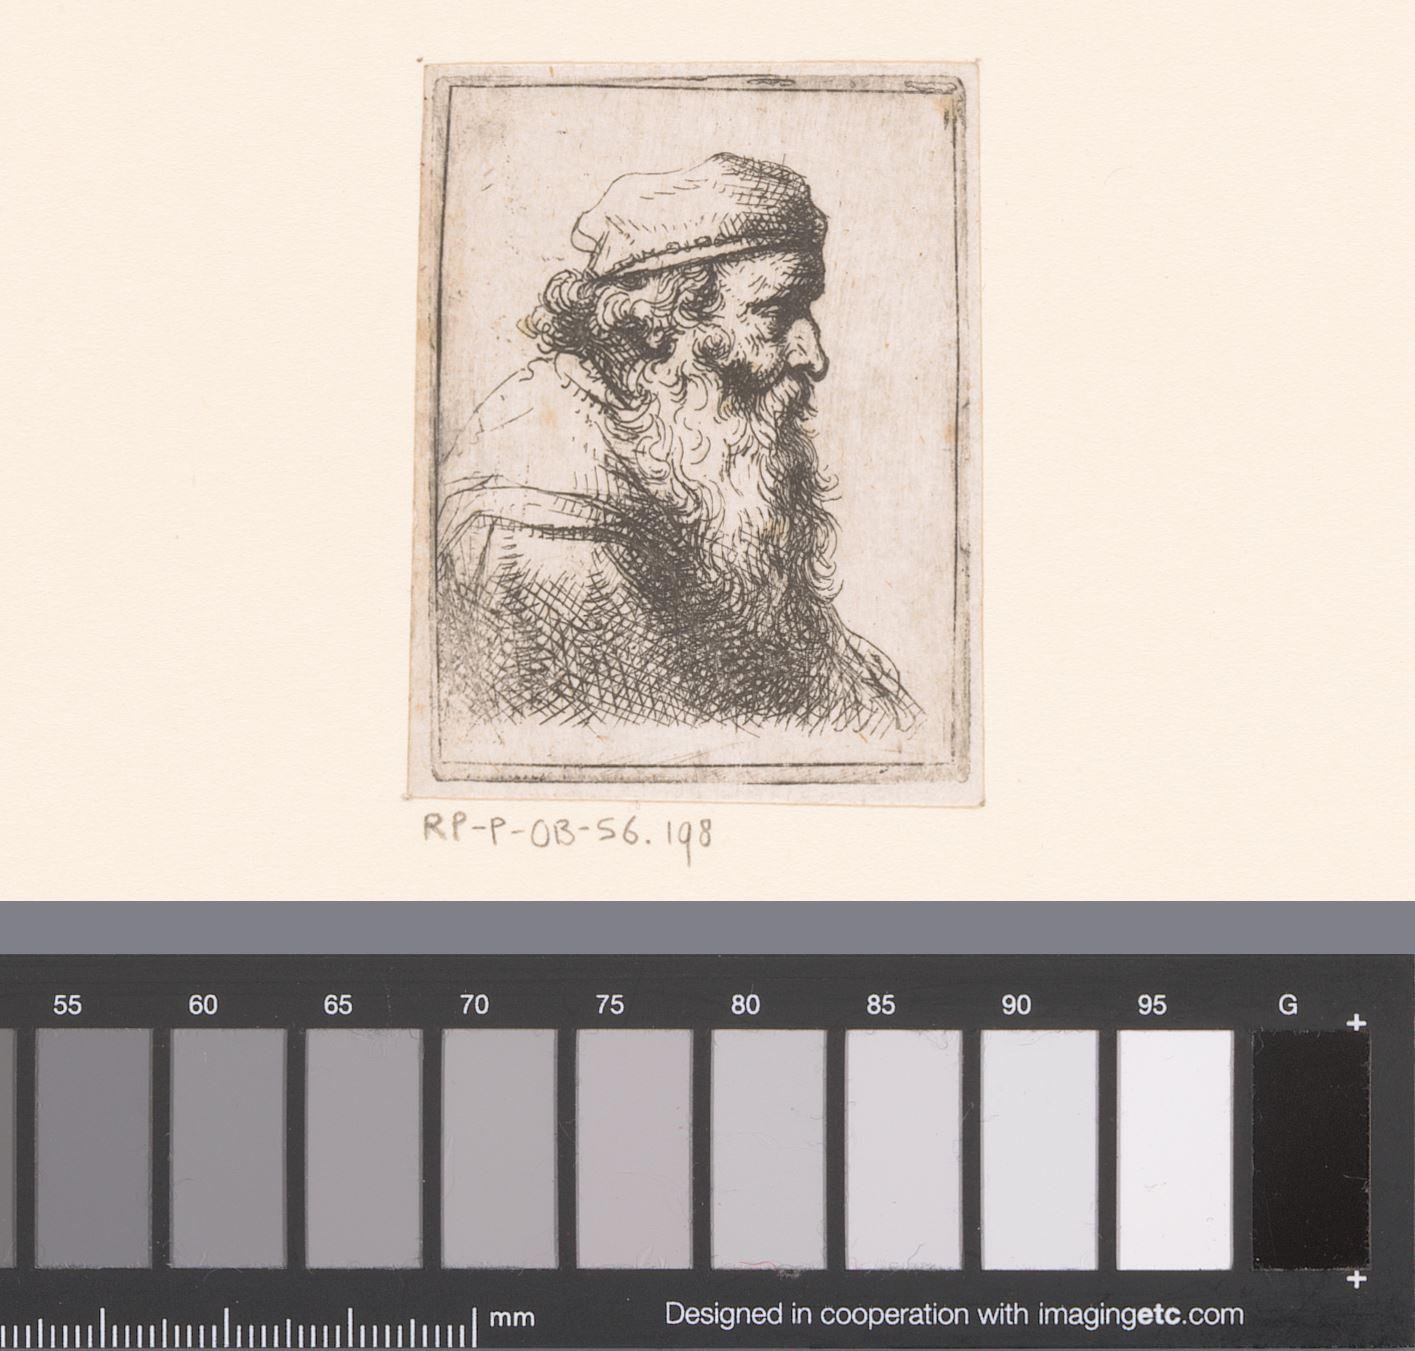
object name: print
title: Oude man met baard en muts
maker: michael willmann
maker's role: draughtsman, print maker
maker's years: 1630-1706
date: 1640-1706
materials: paper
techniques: etching, intaglio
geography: germany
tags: old man, head-gear: cap, beard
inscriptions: collector's mark: Lugt 240, inscription: ‘M Willman?’